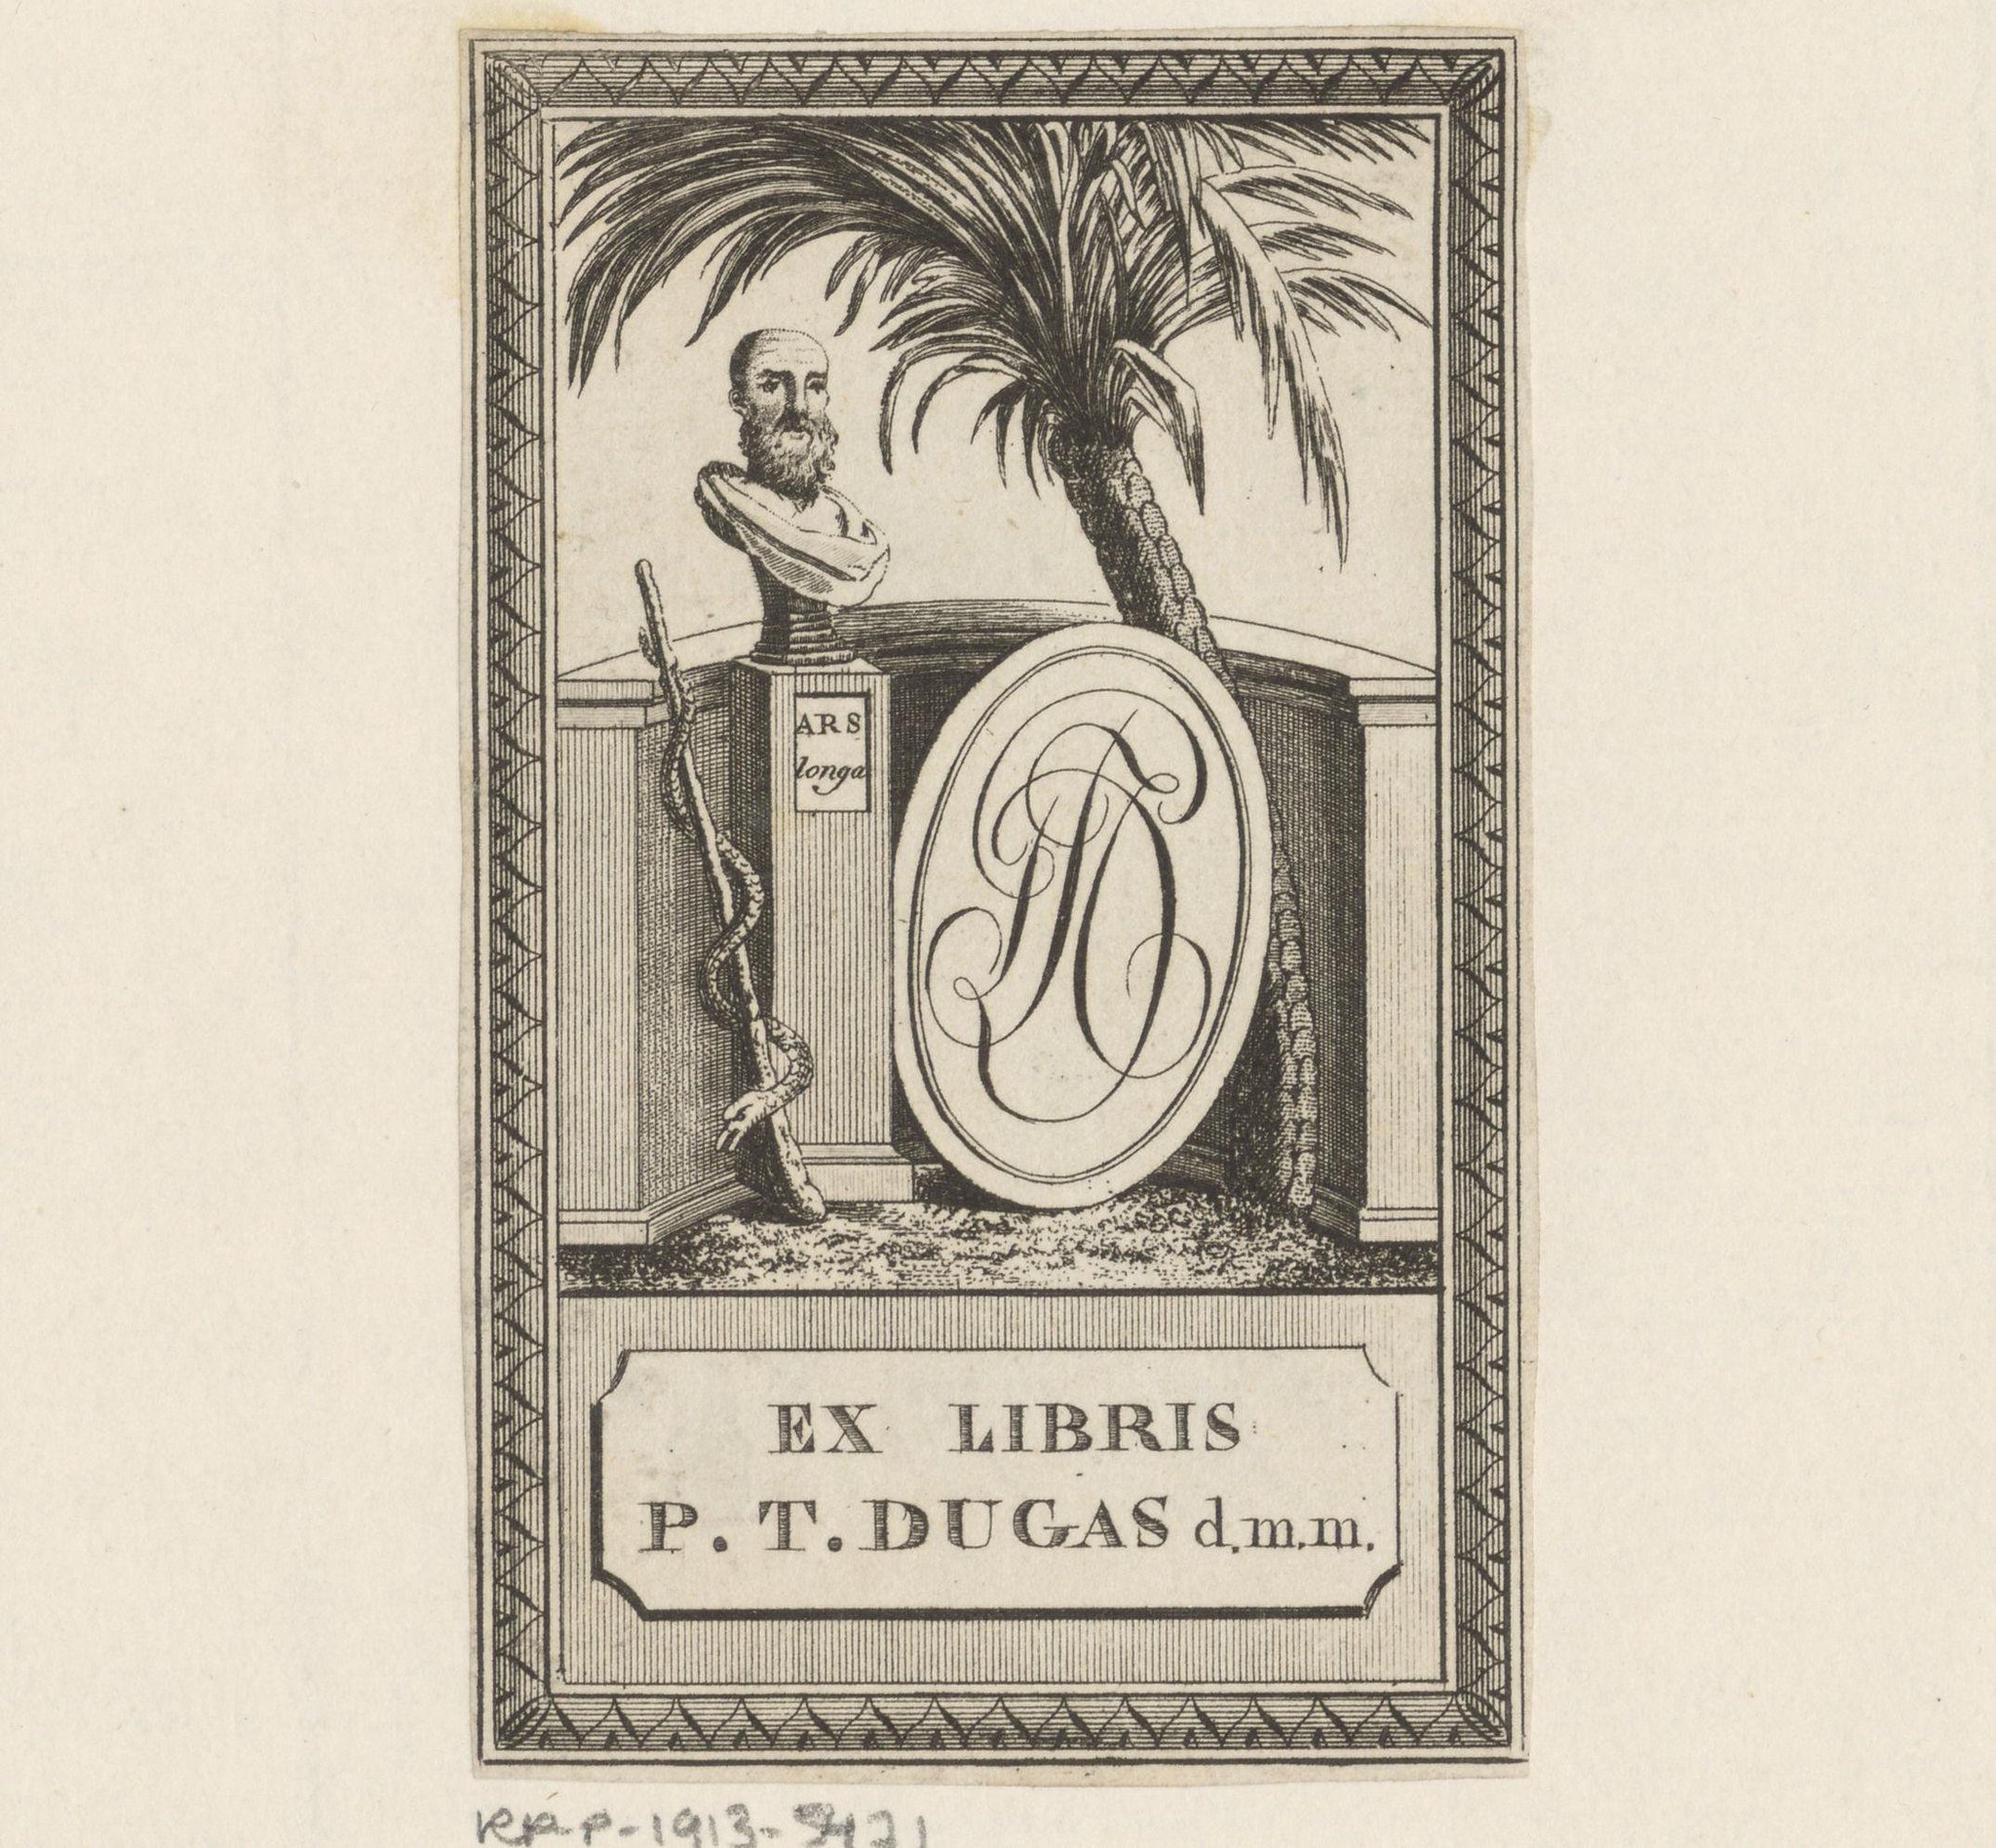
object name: bookplate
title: Ex libris van P.T. Dugas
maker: Anonymous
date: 1700-1899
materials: paper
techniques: engraving, etching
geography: france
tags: chest, bust, old man, (story of) aesculapius (asclepius), aesculapian sign, trees: palm-tree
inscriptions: collector's mark: Lugt 2760, collector's mark: Lugt 2233